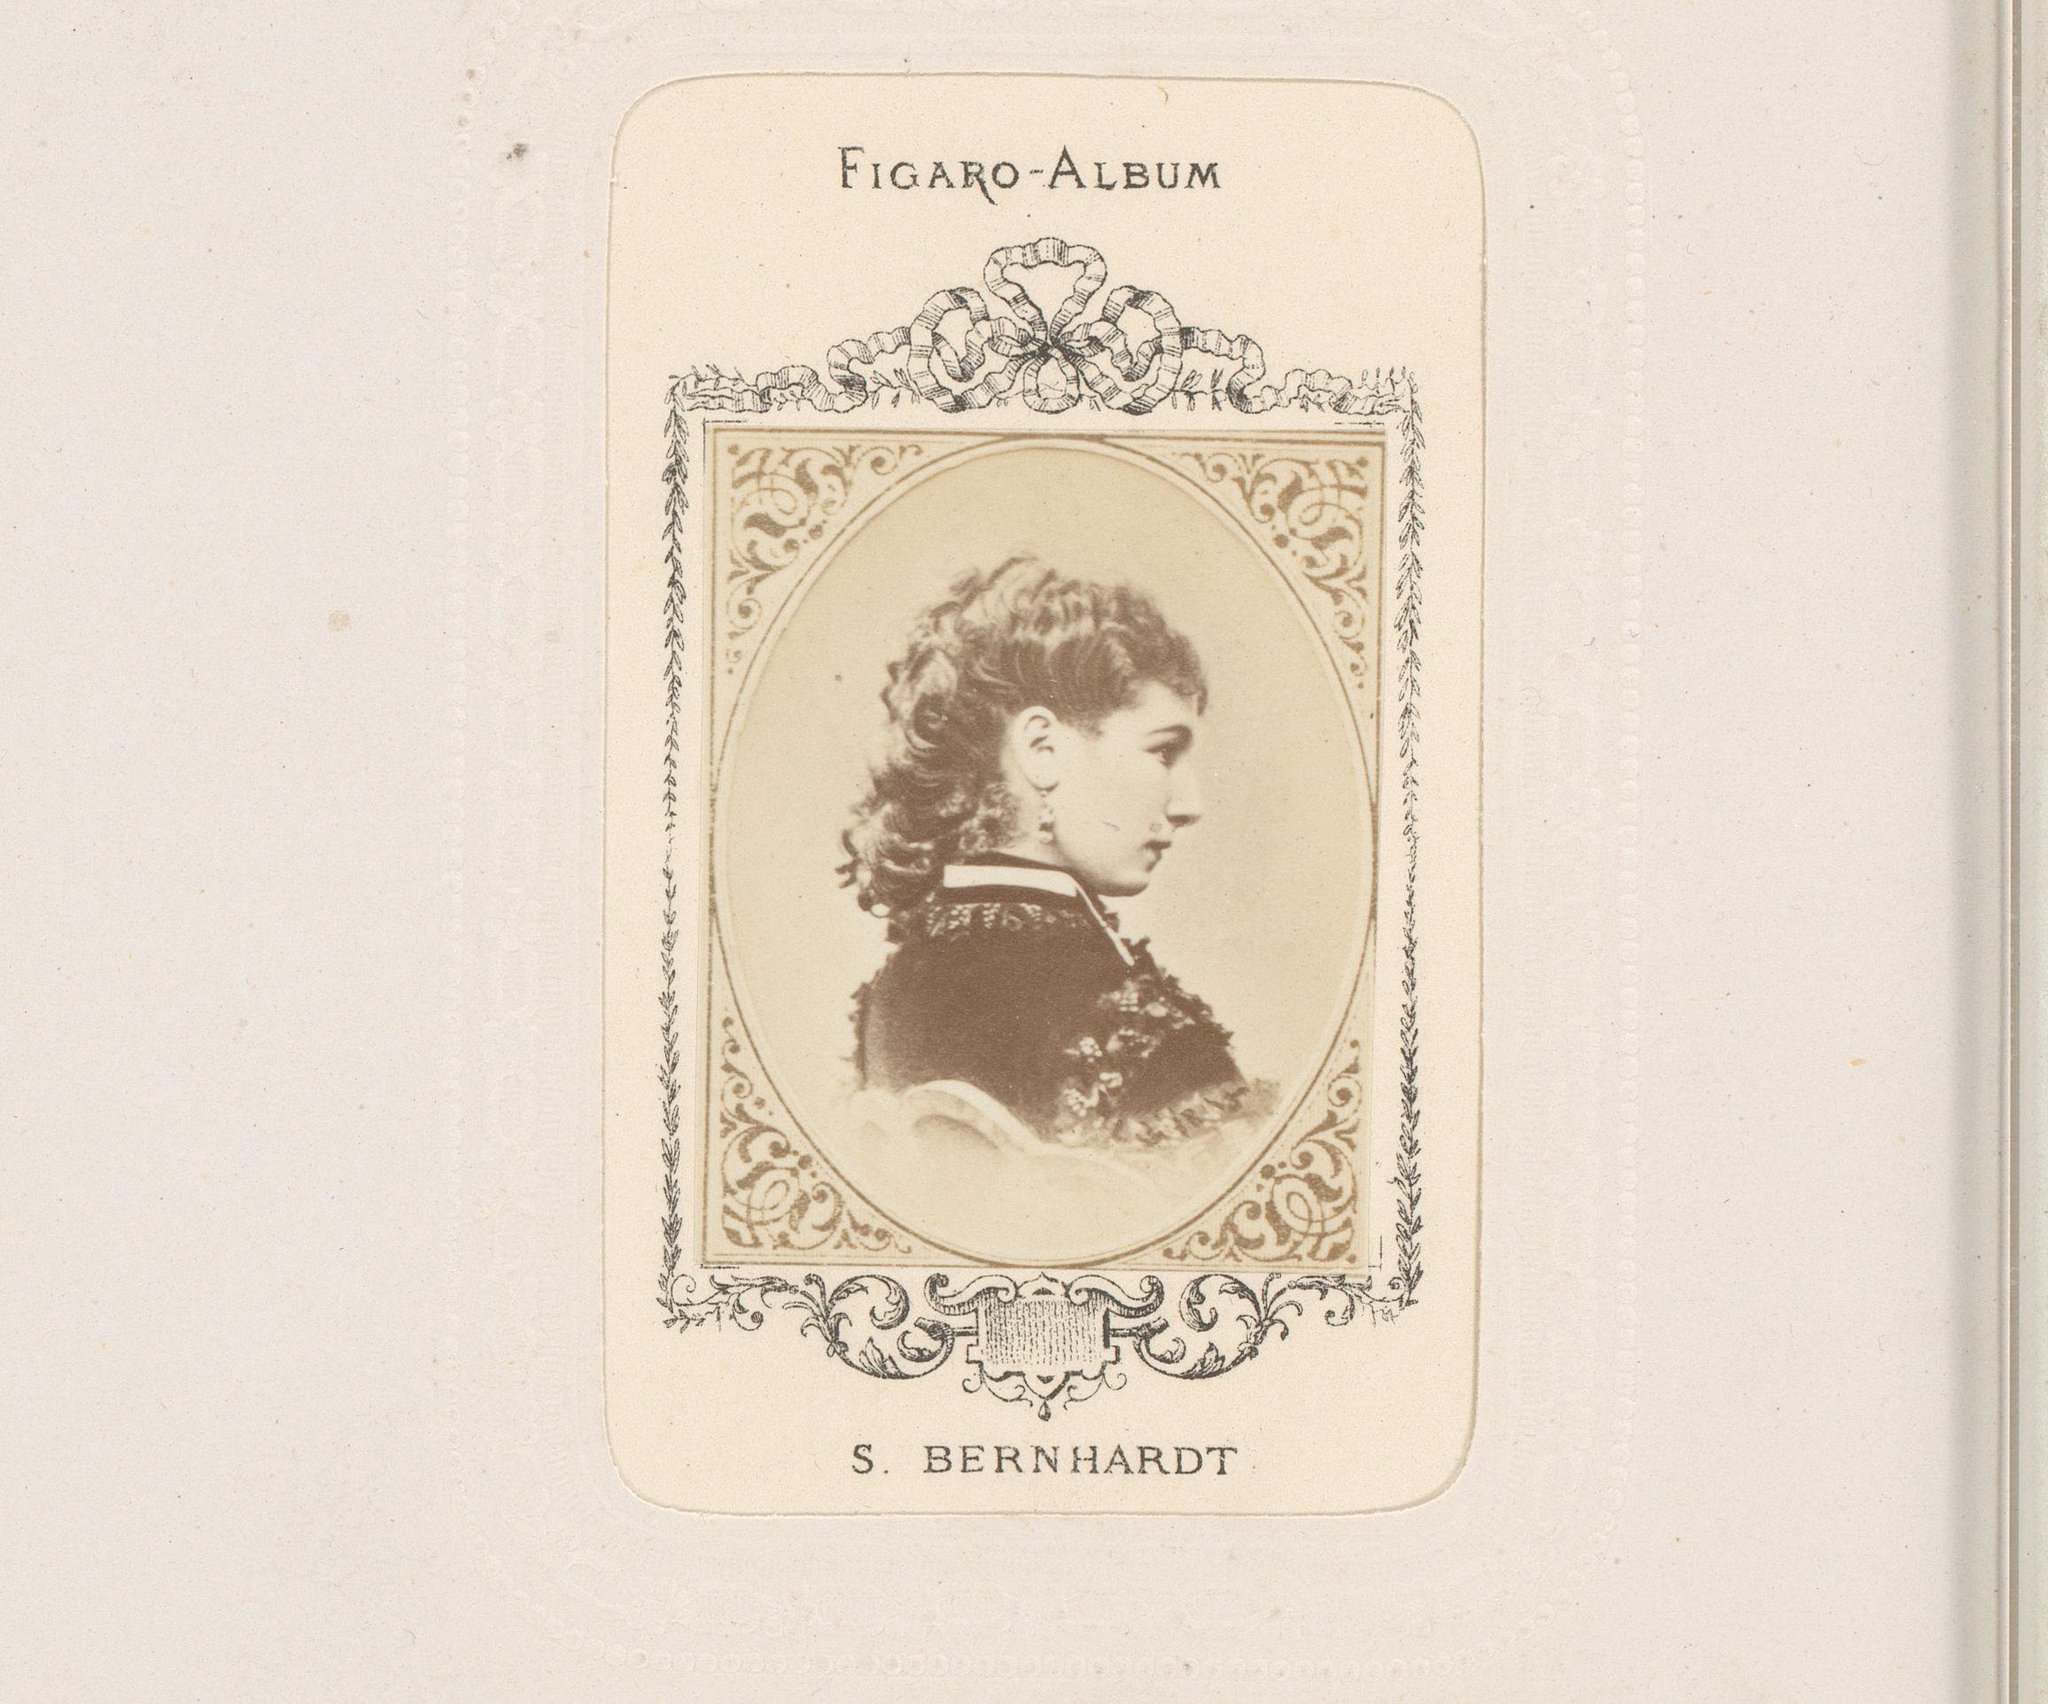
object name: album leaf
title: Fotoreproductie van een portret van Sarah Bernhardt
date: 1860-1900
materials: cardboard, photographic support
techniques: albumen print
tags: sculptor, sarah bernhardt, historical persons - bb - woman, portrait of actor, actress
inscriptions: inscription: ‘Figaro-Album/ S. Bernhardt/ d'après Mulnier Phot.’